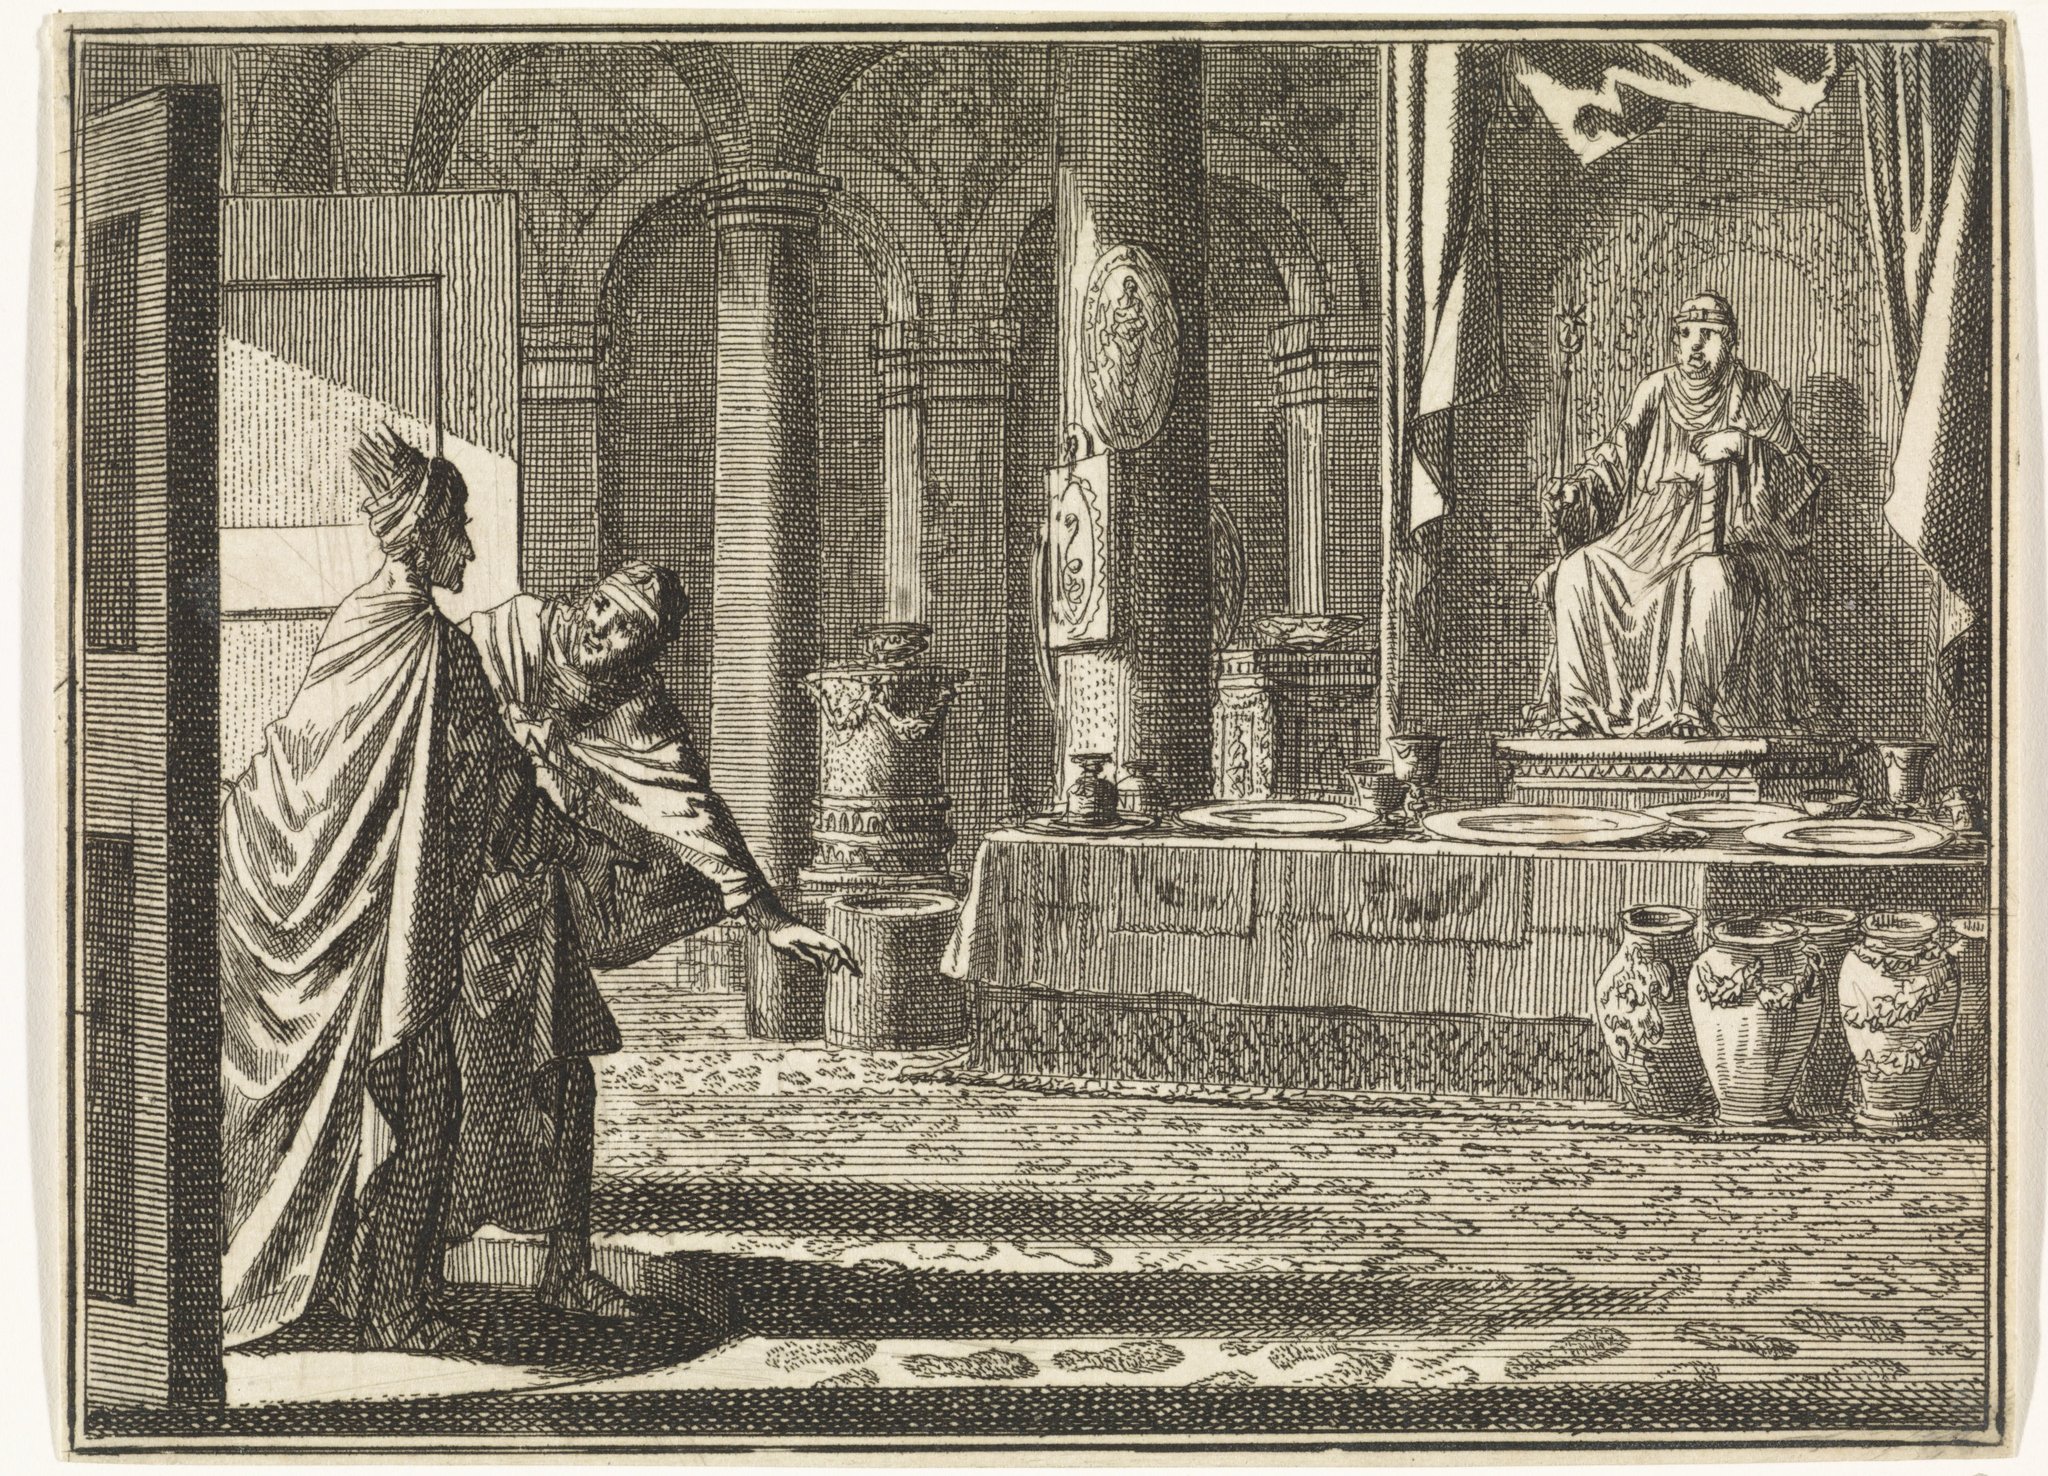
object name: print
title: Daniël toont aan Cyrus de voetstappen op de grond van de tempel van Bel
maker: jan luyken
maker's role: draughtsman, print maker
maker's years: 1649-1712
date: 1712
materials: paper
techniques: etching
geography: amsterdam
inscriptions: collector's mark: Lugt 2228, number: ‘168’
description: Illustratie uit: Luyken, Jan. De schriftuurlyke geschiedenissen en gelykenissen van het Oude en Nieuwe Verbond, 2 delen. Amsterdam: Wed. Pieter Arentsz II en Cornelis van der Sys, 1712, dl. I.